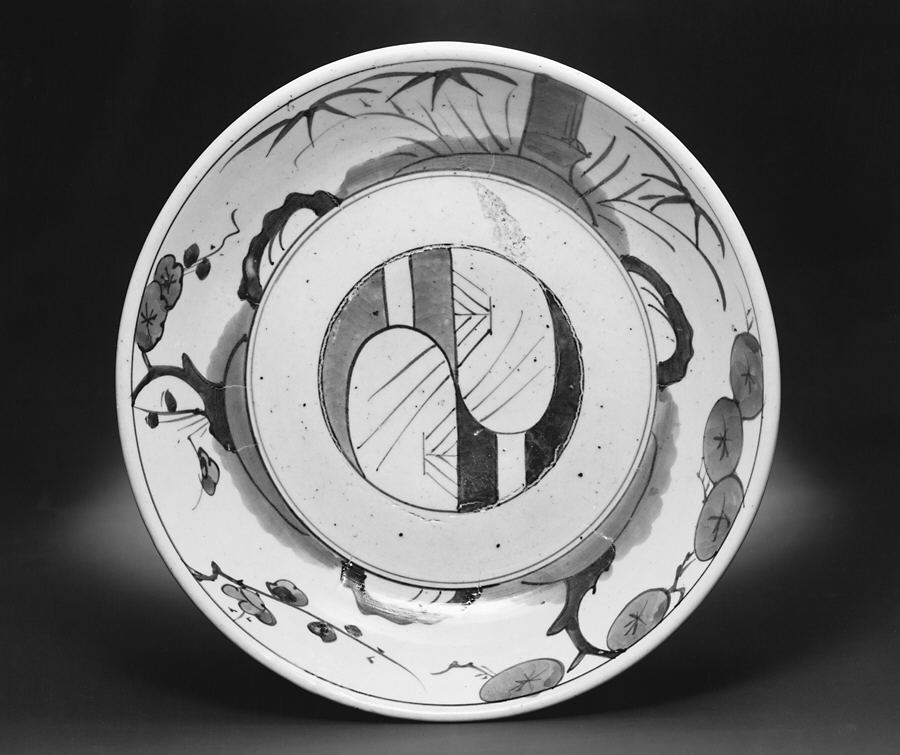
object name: dish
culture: japanese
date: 1701-1800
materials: porcelain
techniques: underglaze